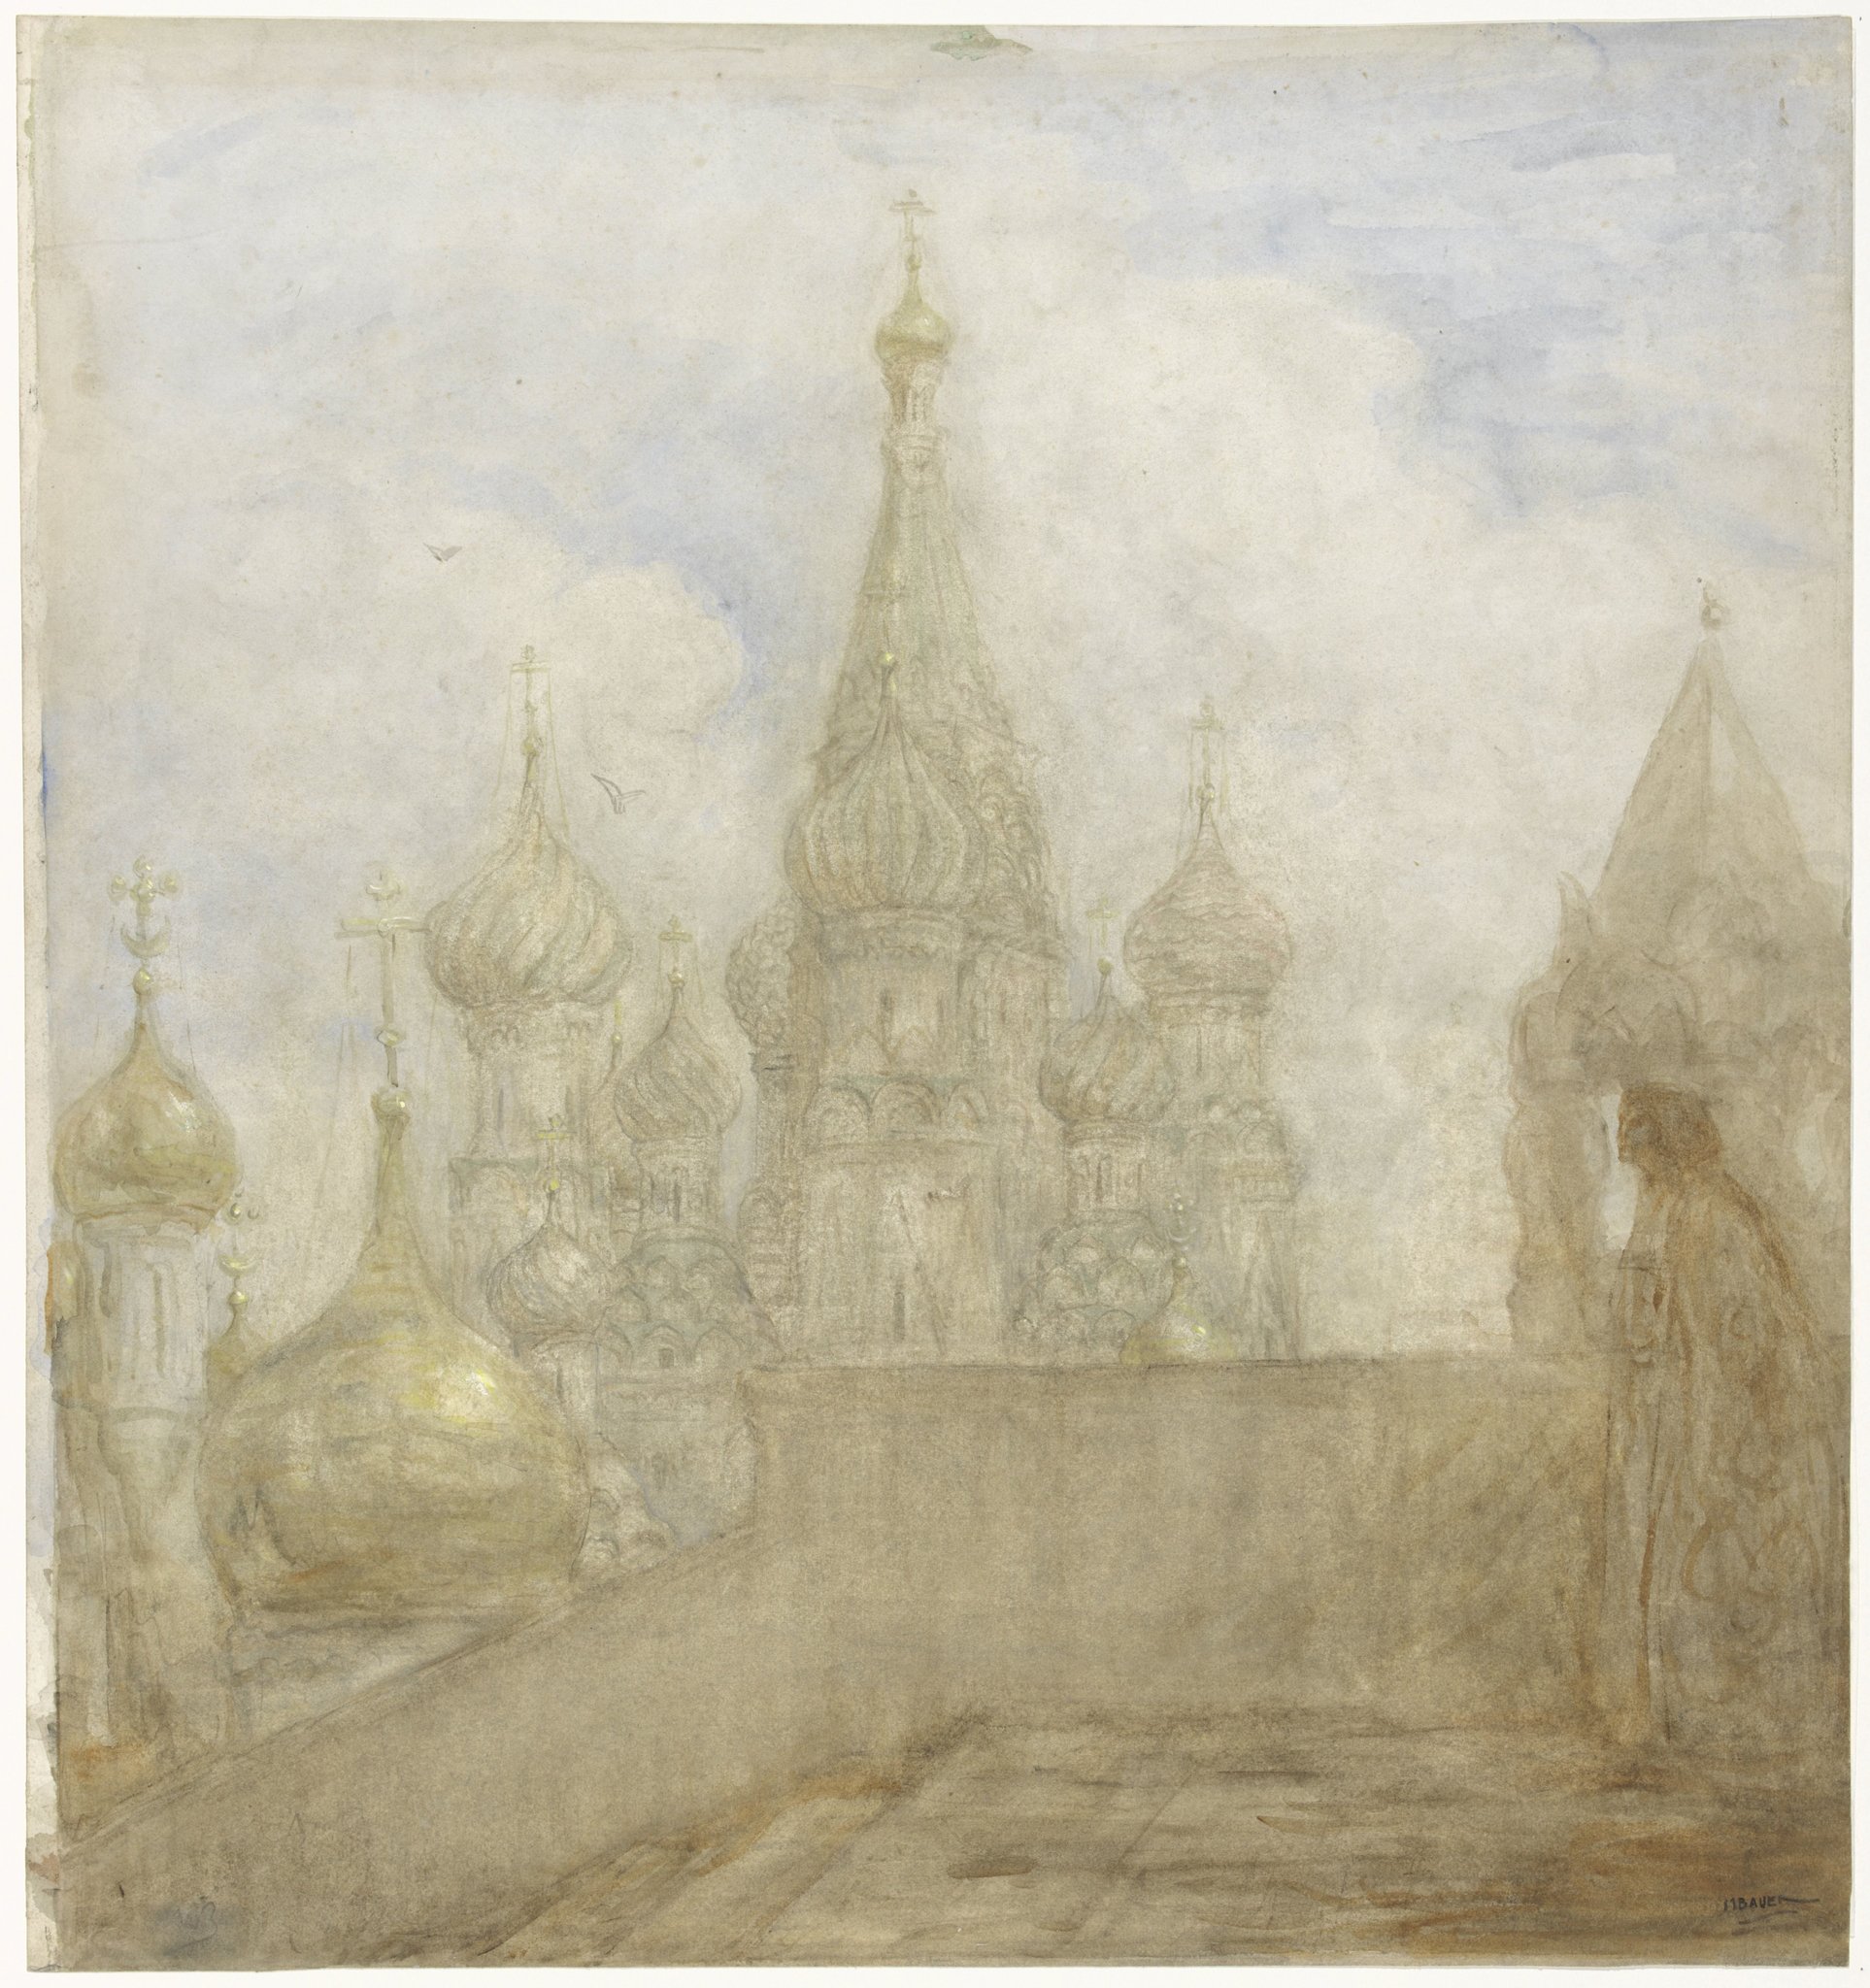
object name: drawing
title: De St. Basiliuskathedraal te Moskou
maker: marius bauer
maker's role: draughtsman, print maker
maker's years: 1867-1932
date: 1898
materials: paper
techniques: brush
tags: public road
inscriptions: signature: ‘M Bauer’